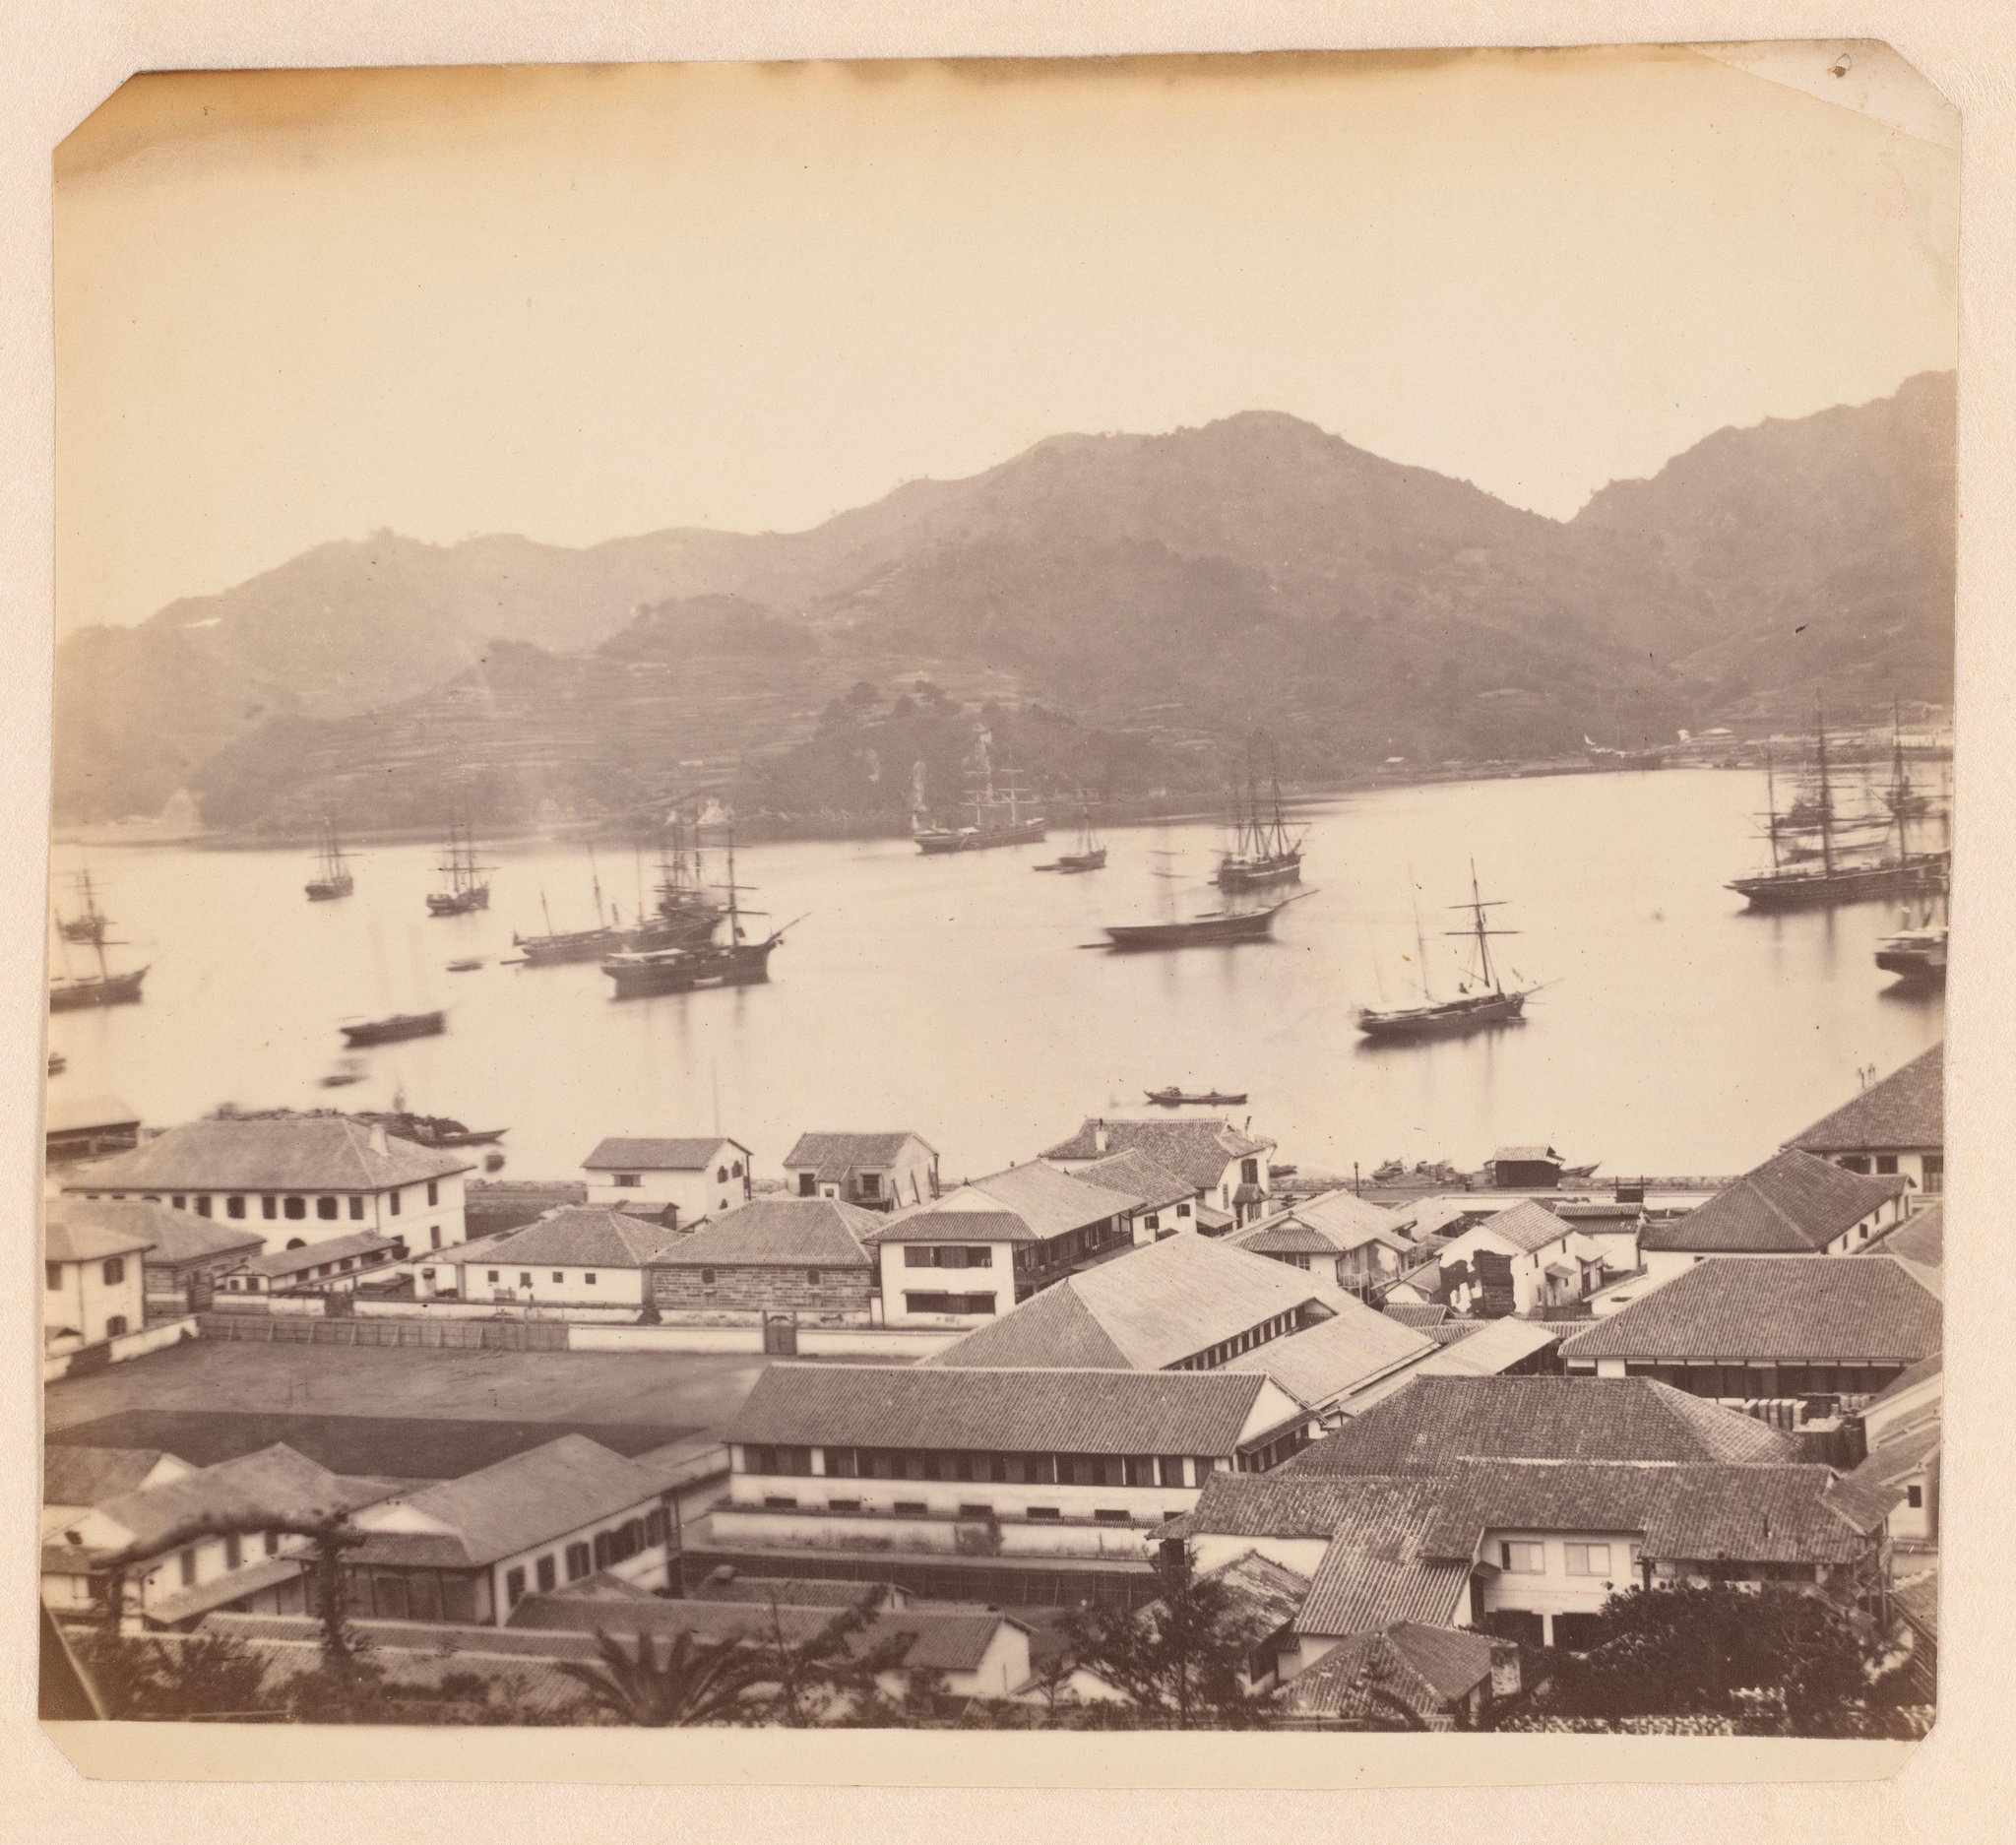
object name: photograph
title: Oura, Nagasaki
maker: Anonymous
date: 1865-1870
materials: paper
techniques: albumen print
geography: japan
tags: japan